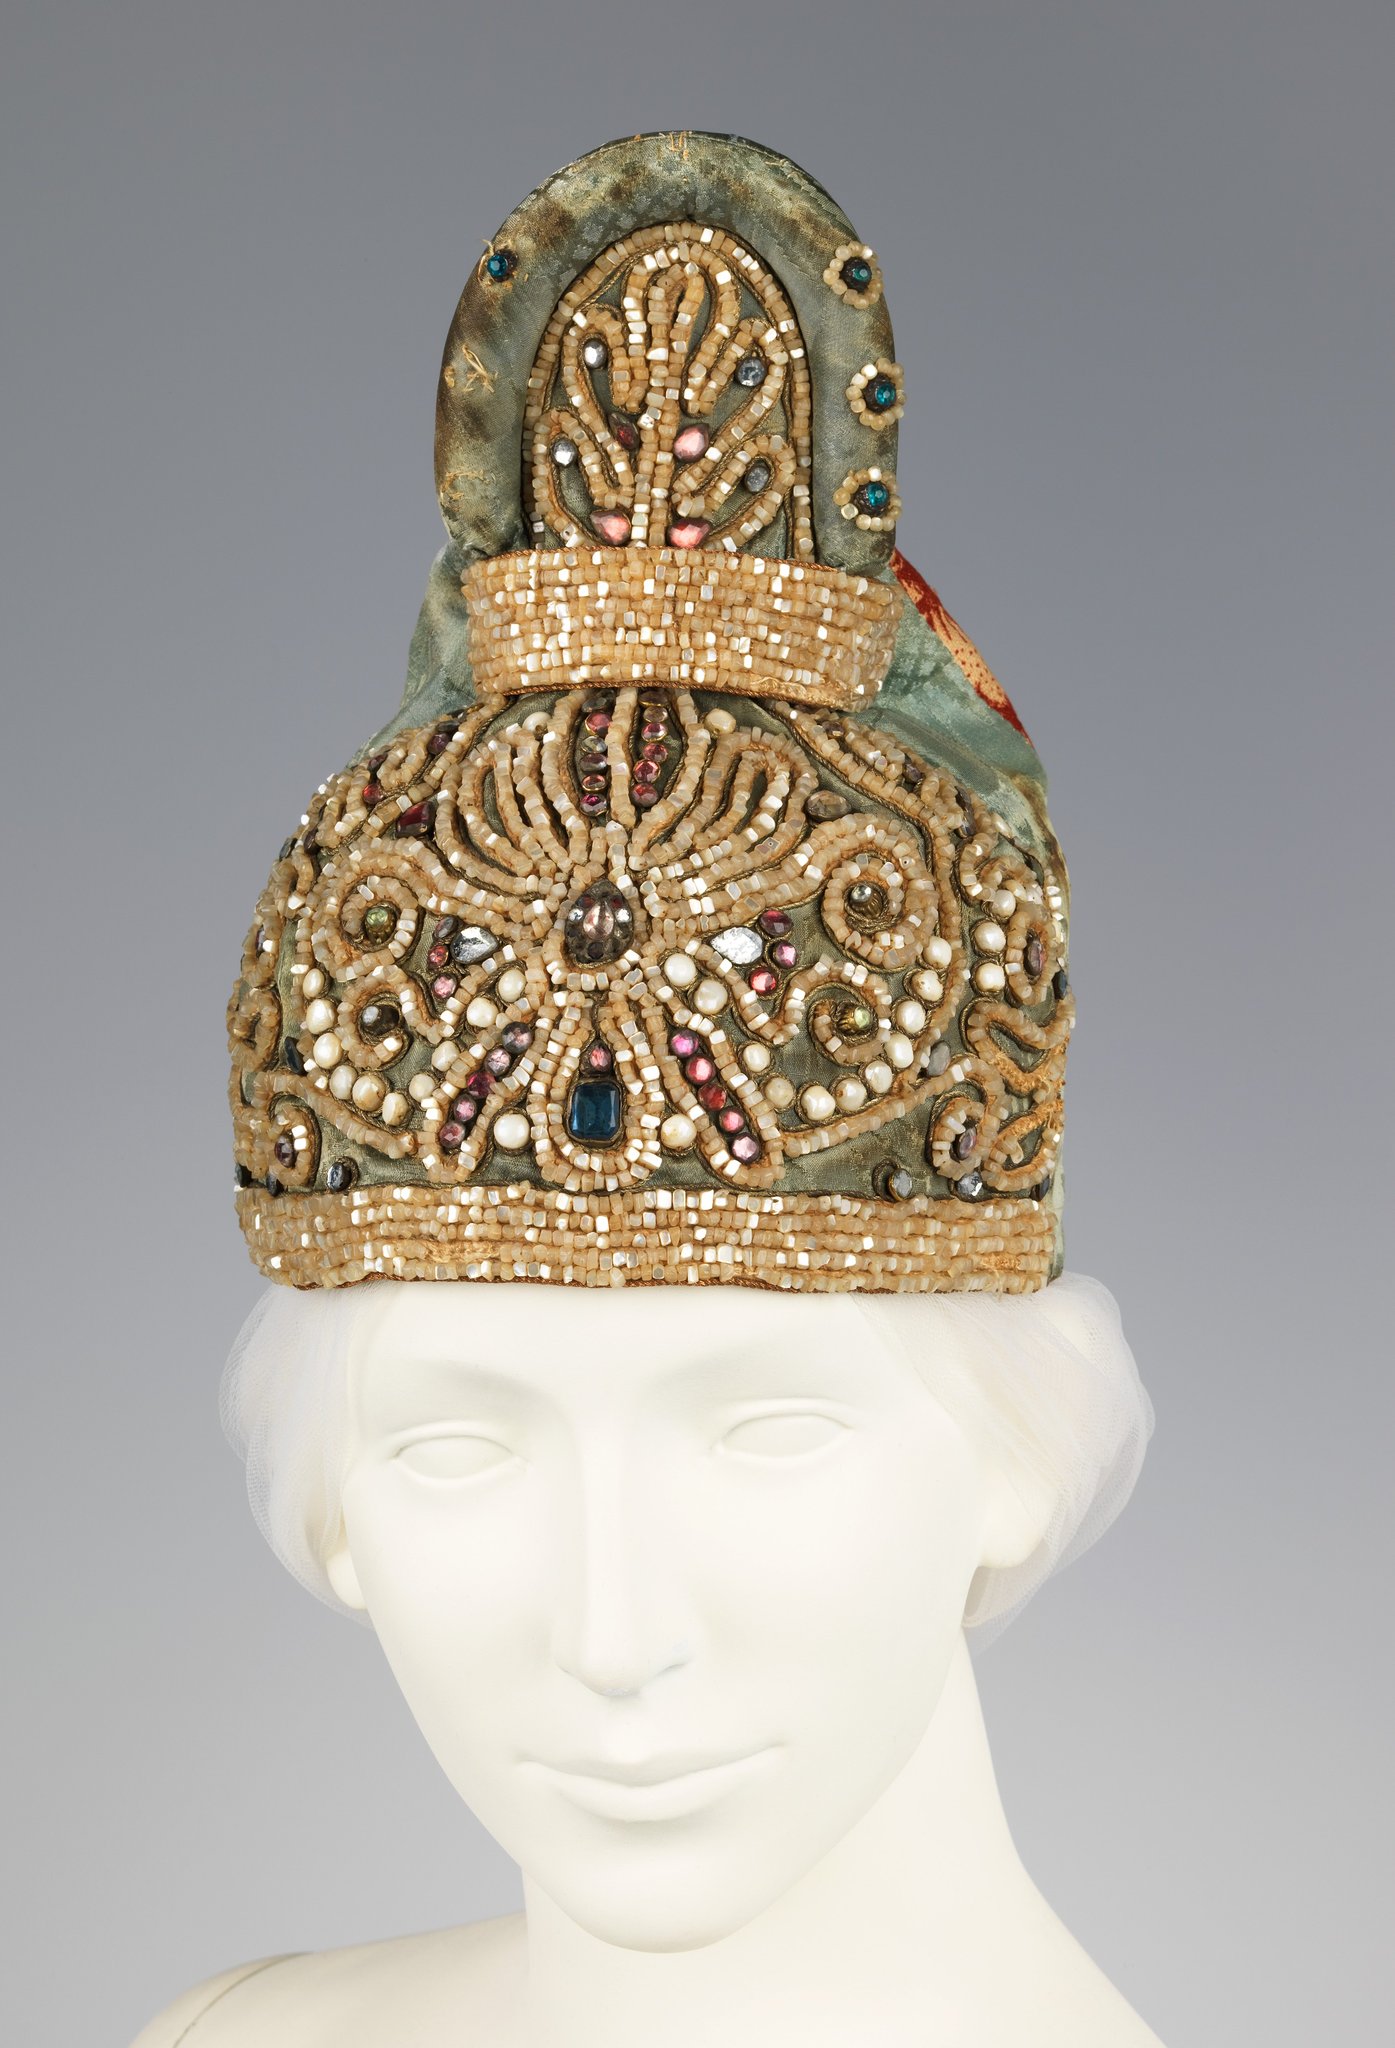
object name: headdress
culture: russian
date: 1801-1825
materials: glass, linen, metal, mother of pearl, silk